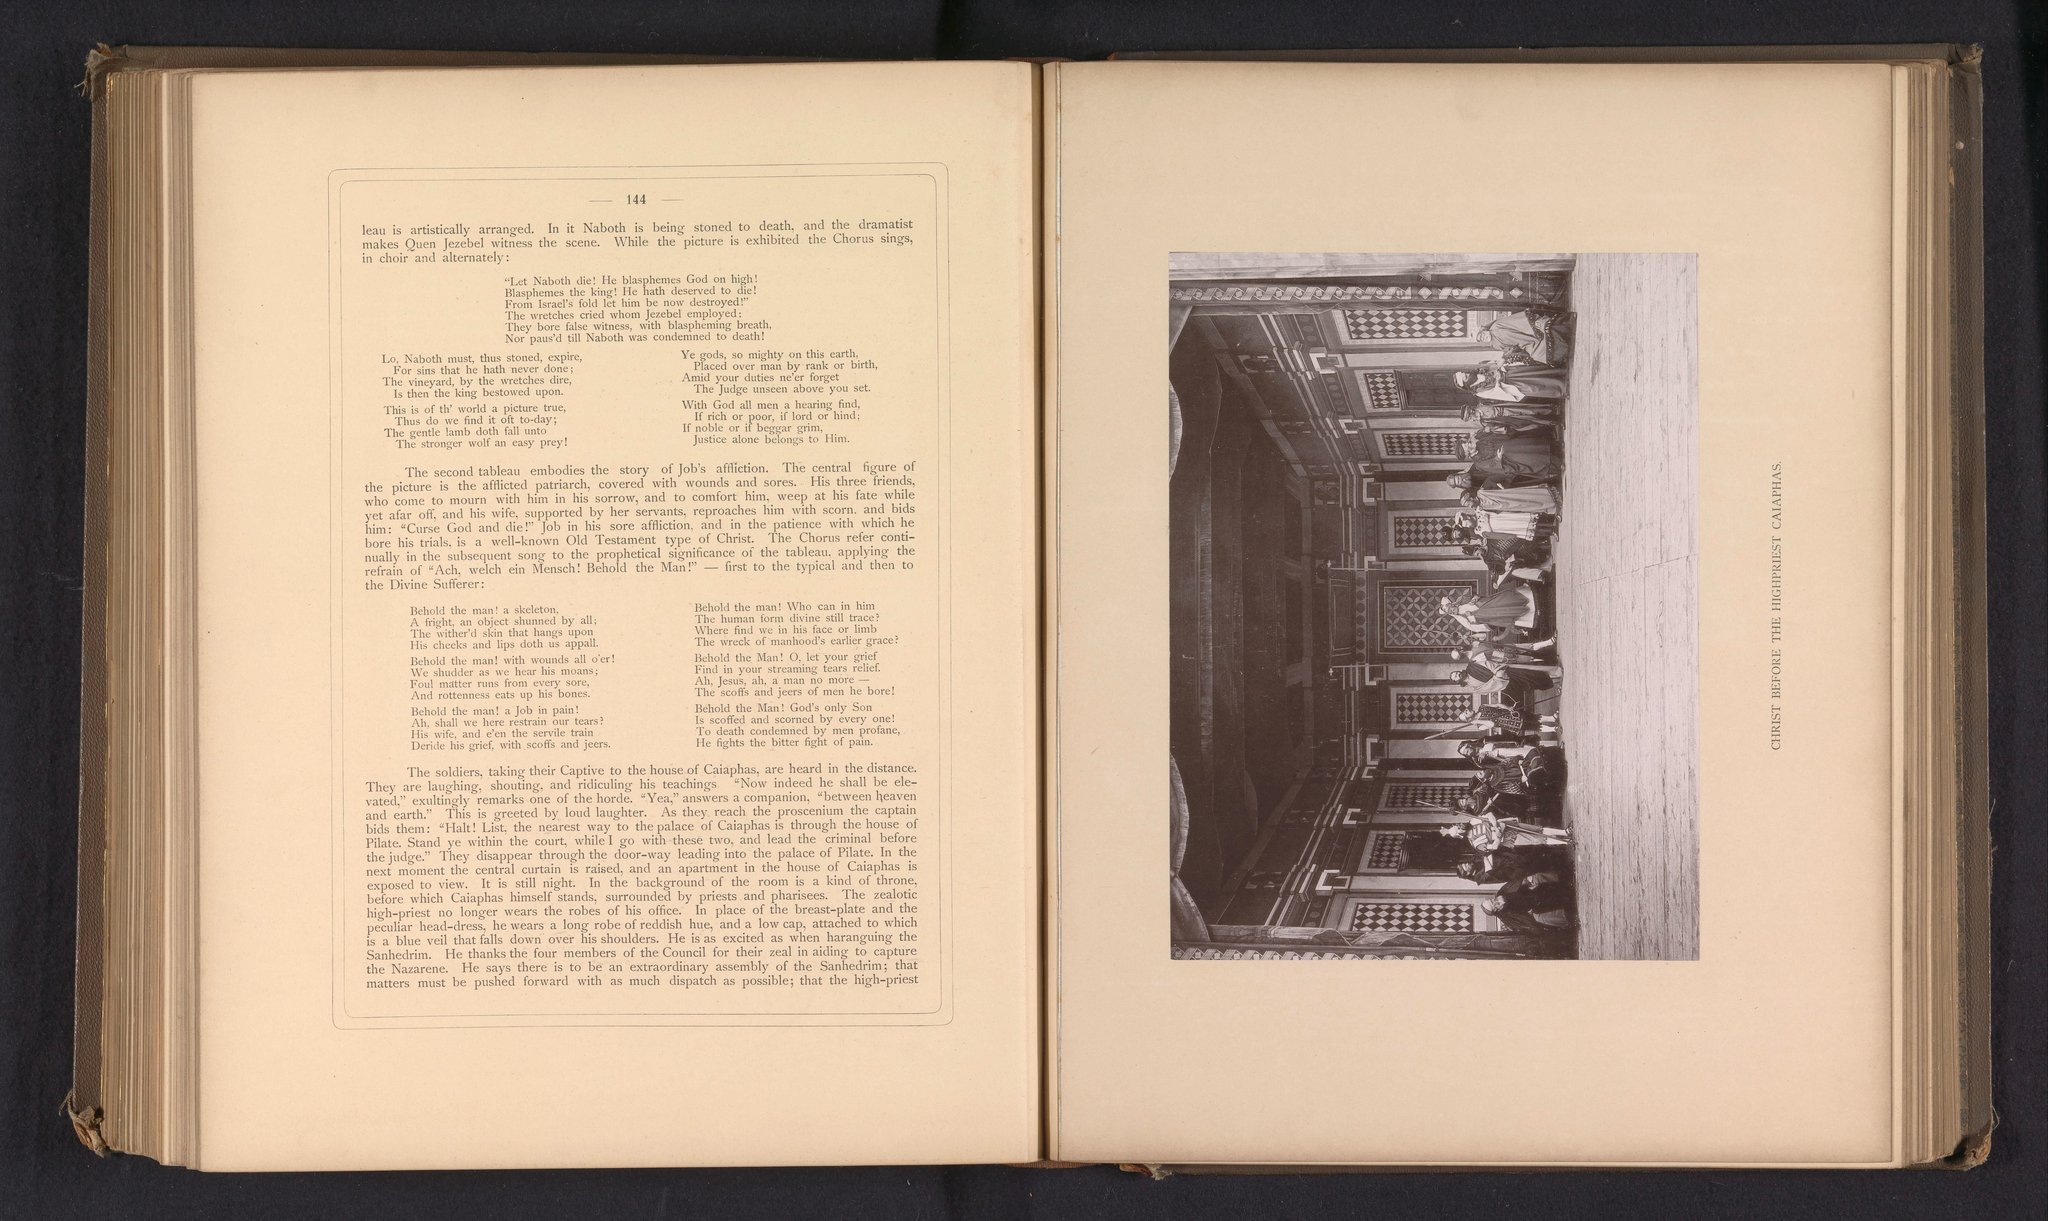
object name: photomechanical print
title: Christ before the highpriest Caiaphas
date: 1885-1890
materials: paper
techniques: photograph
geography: oberammergau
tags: christ before the sanhedrin with caiaphas as high priest, and possibly annas; maybe a soldier about to strike christ because he keeps silent (matthew 26:57-66; mark 14:53-64; luke 22:54, 22:66-71), group of actors, troupe; actors on the stage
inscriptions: inscription: ‘Gemeinde Oberammergau Passionsspiel 1890’